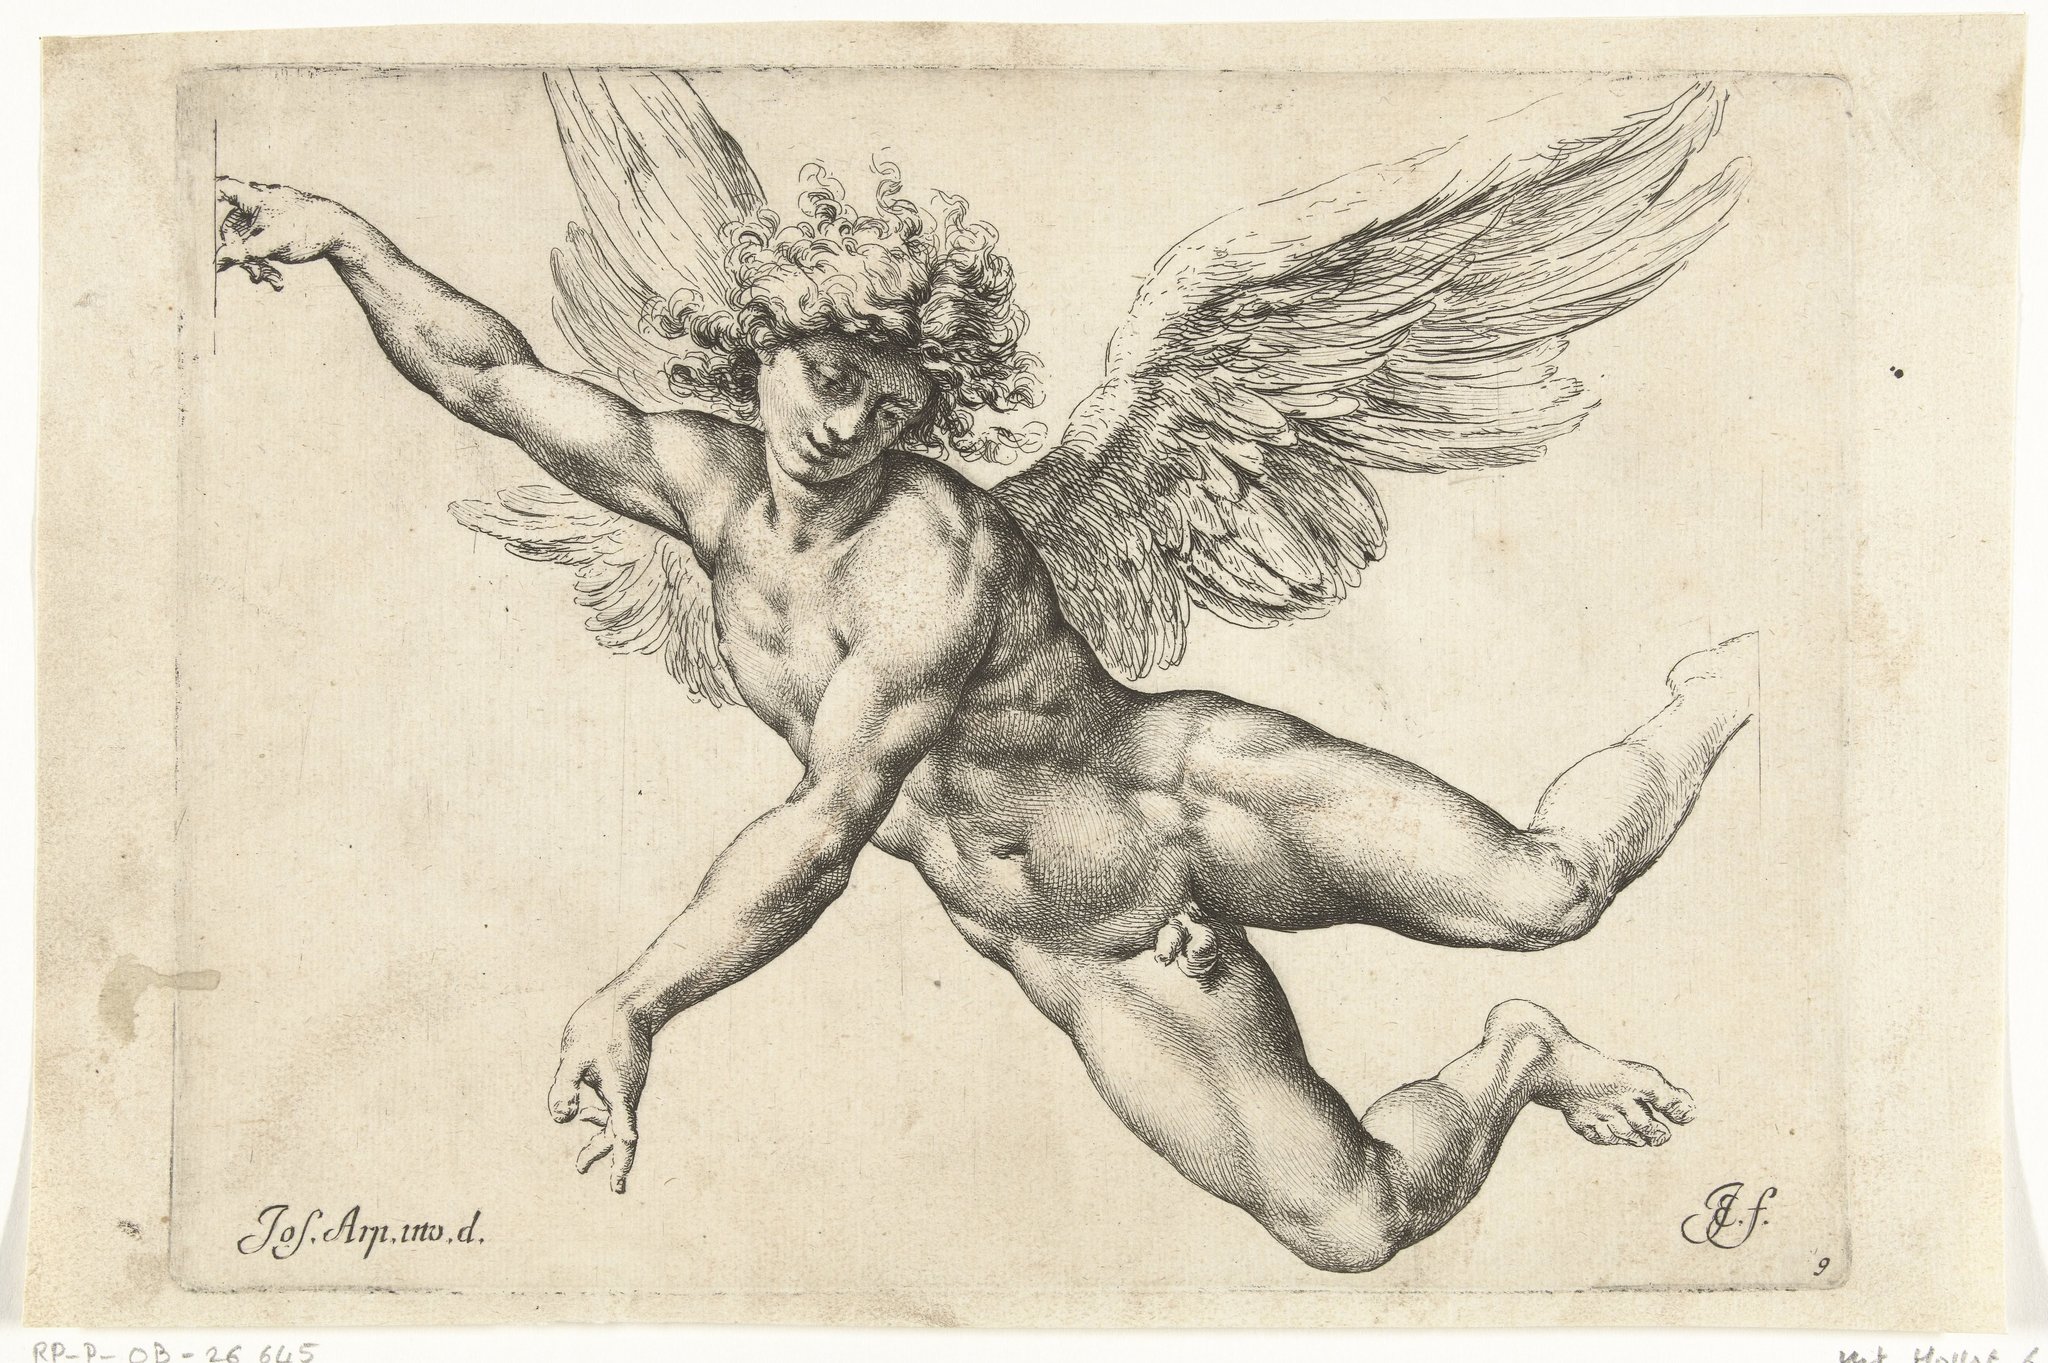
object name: print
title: Paradigmata graphices variorum artificum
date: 1668-1671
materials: paper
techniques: etching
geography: northern netherlands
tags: the archangel michael (often in armour with sword or lance), (story of) icarus, son of daedalus, angels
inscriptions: collector's mark: Lugt 2228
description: afkomstig uit: Paradigmata graphices variorum artificum : voor-beelden der teken-konst van verscheyde meesters, Hagae-Comitis, 1671.